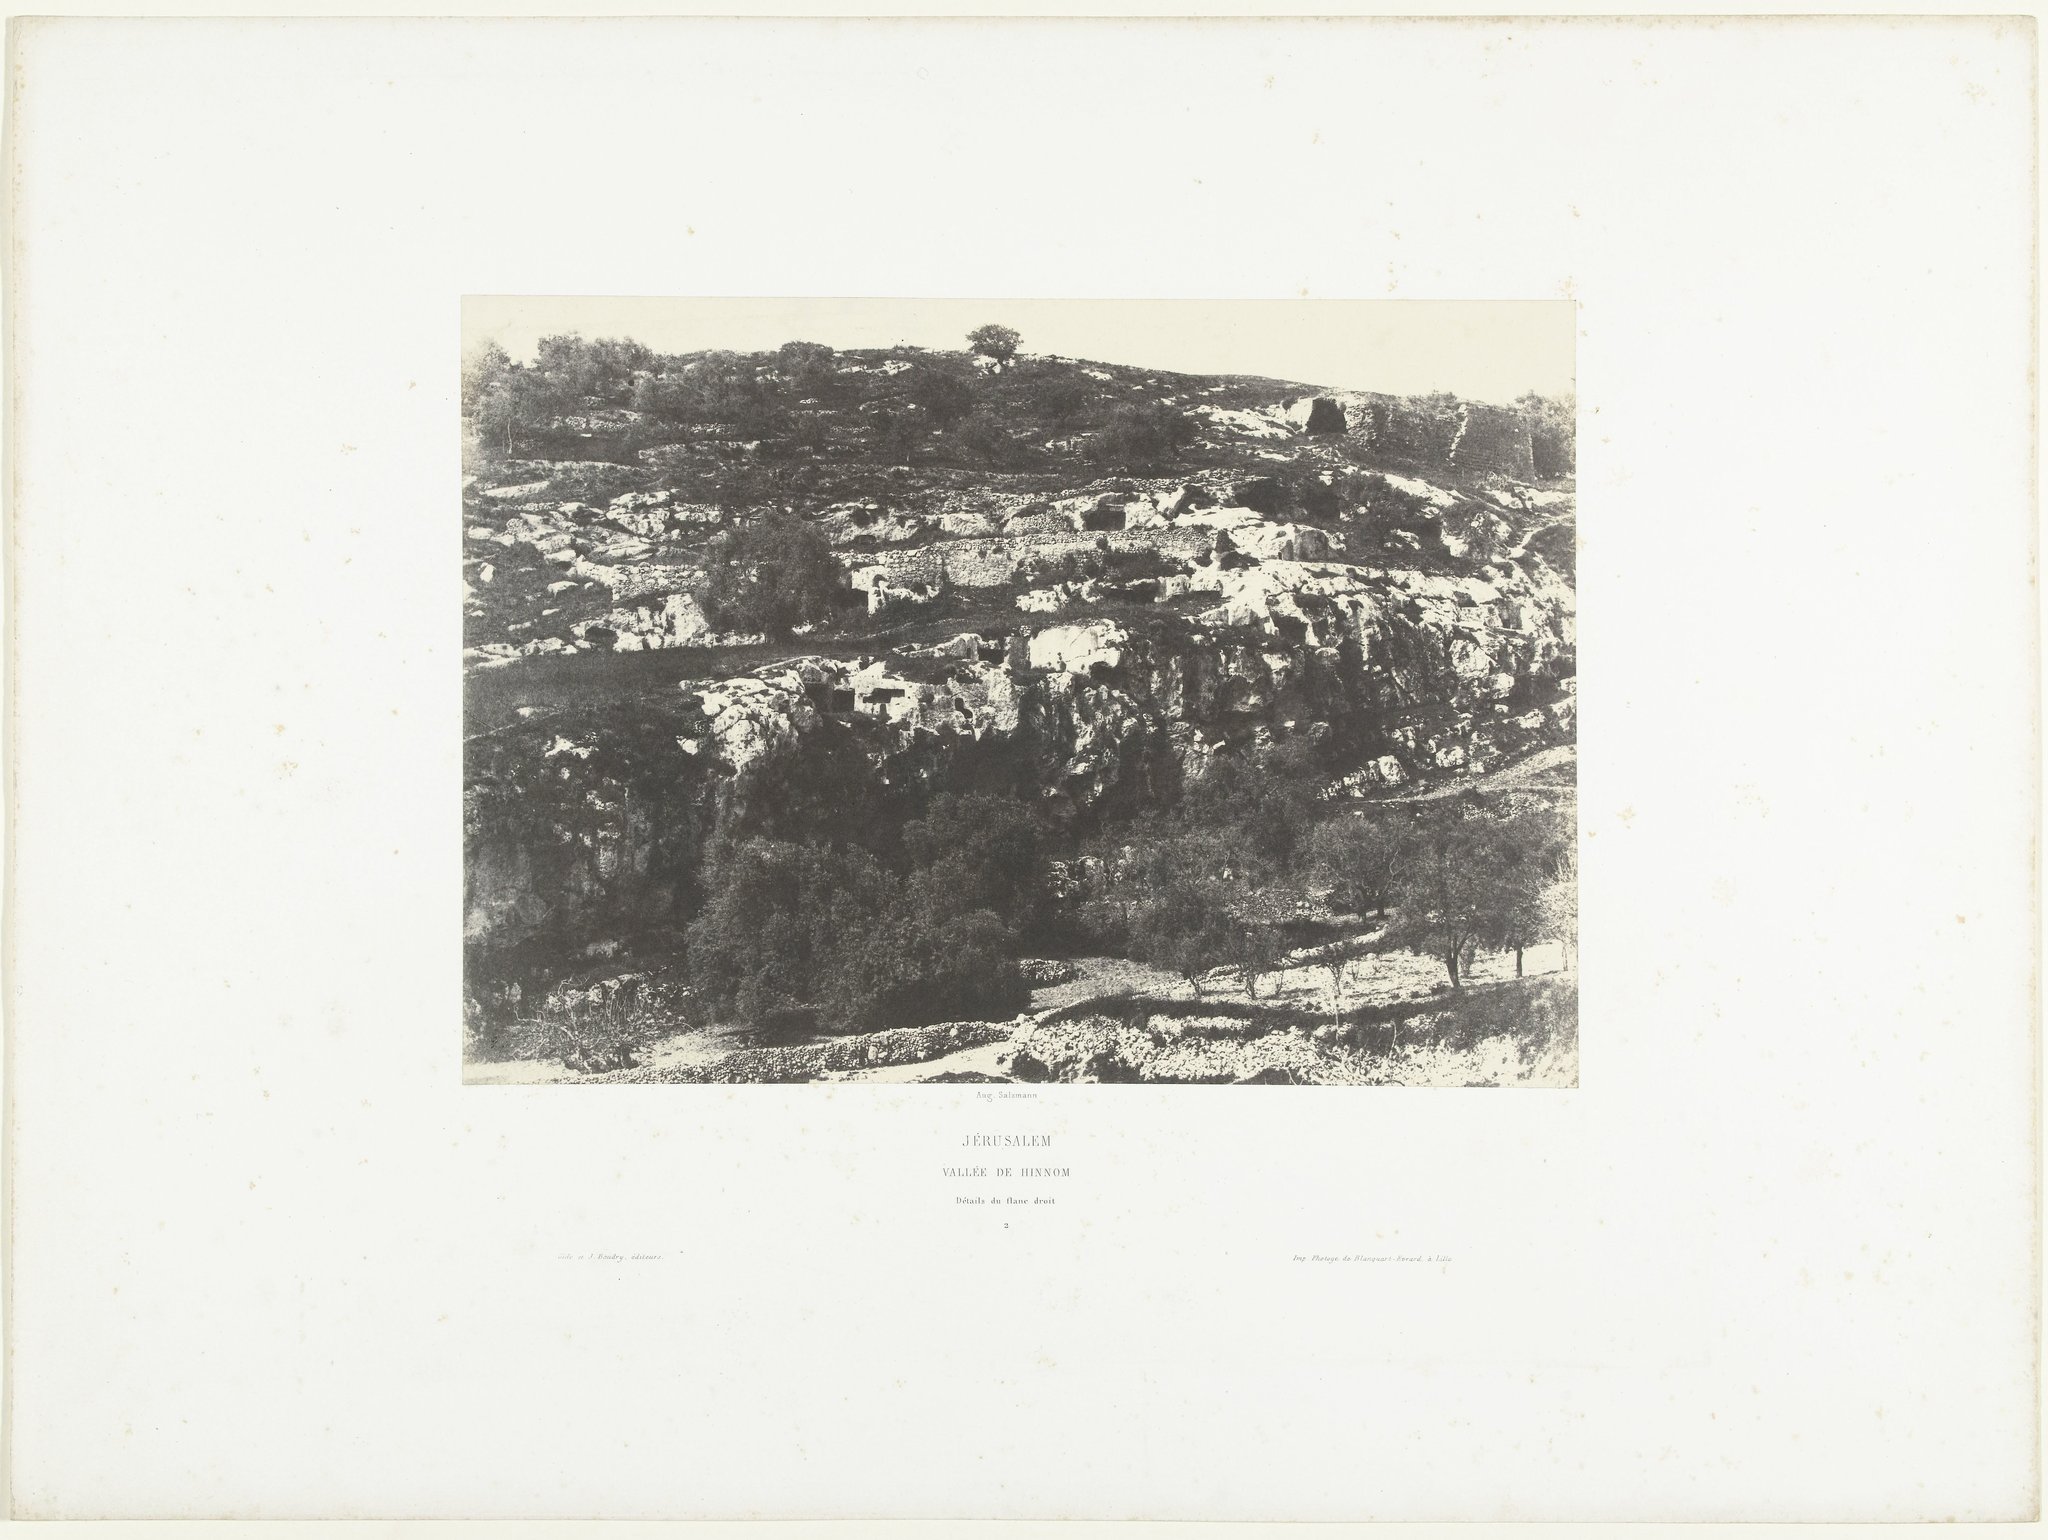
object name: photograph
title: Jérusalem Valléé de Hinnom Détails du flanc droît 2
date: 1856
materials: paper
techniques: salted paper print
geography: lille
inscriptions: title: ‘JÉRUSALEM VALLÉÉ DE HINNOM Détails du flanc droit 2’, signature: ‘Aug. Salzmann’, annotation: ‘Gide et J. Baudry, éditeurs.’, annotation: ‘Imp. Photogr. de Blanquart-Evrard, à Lille’